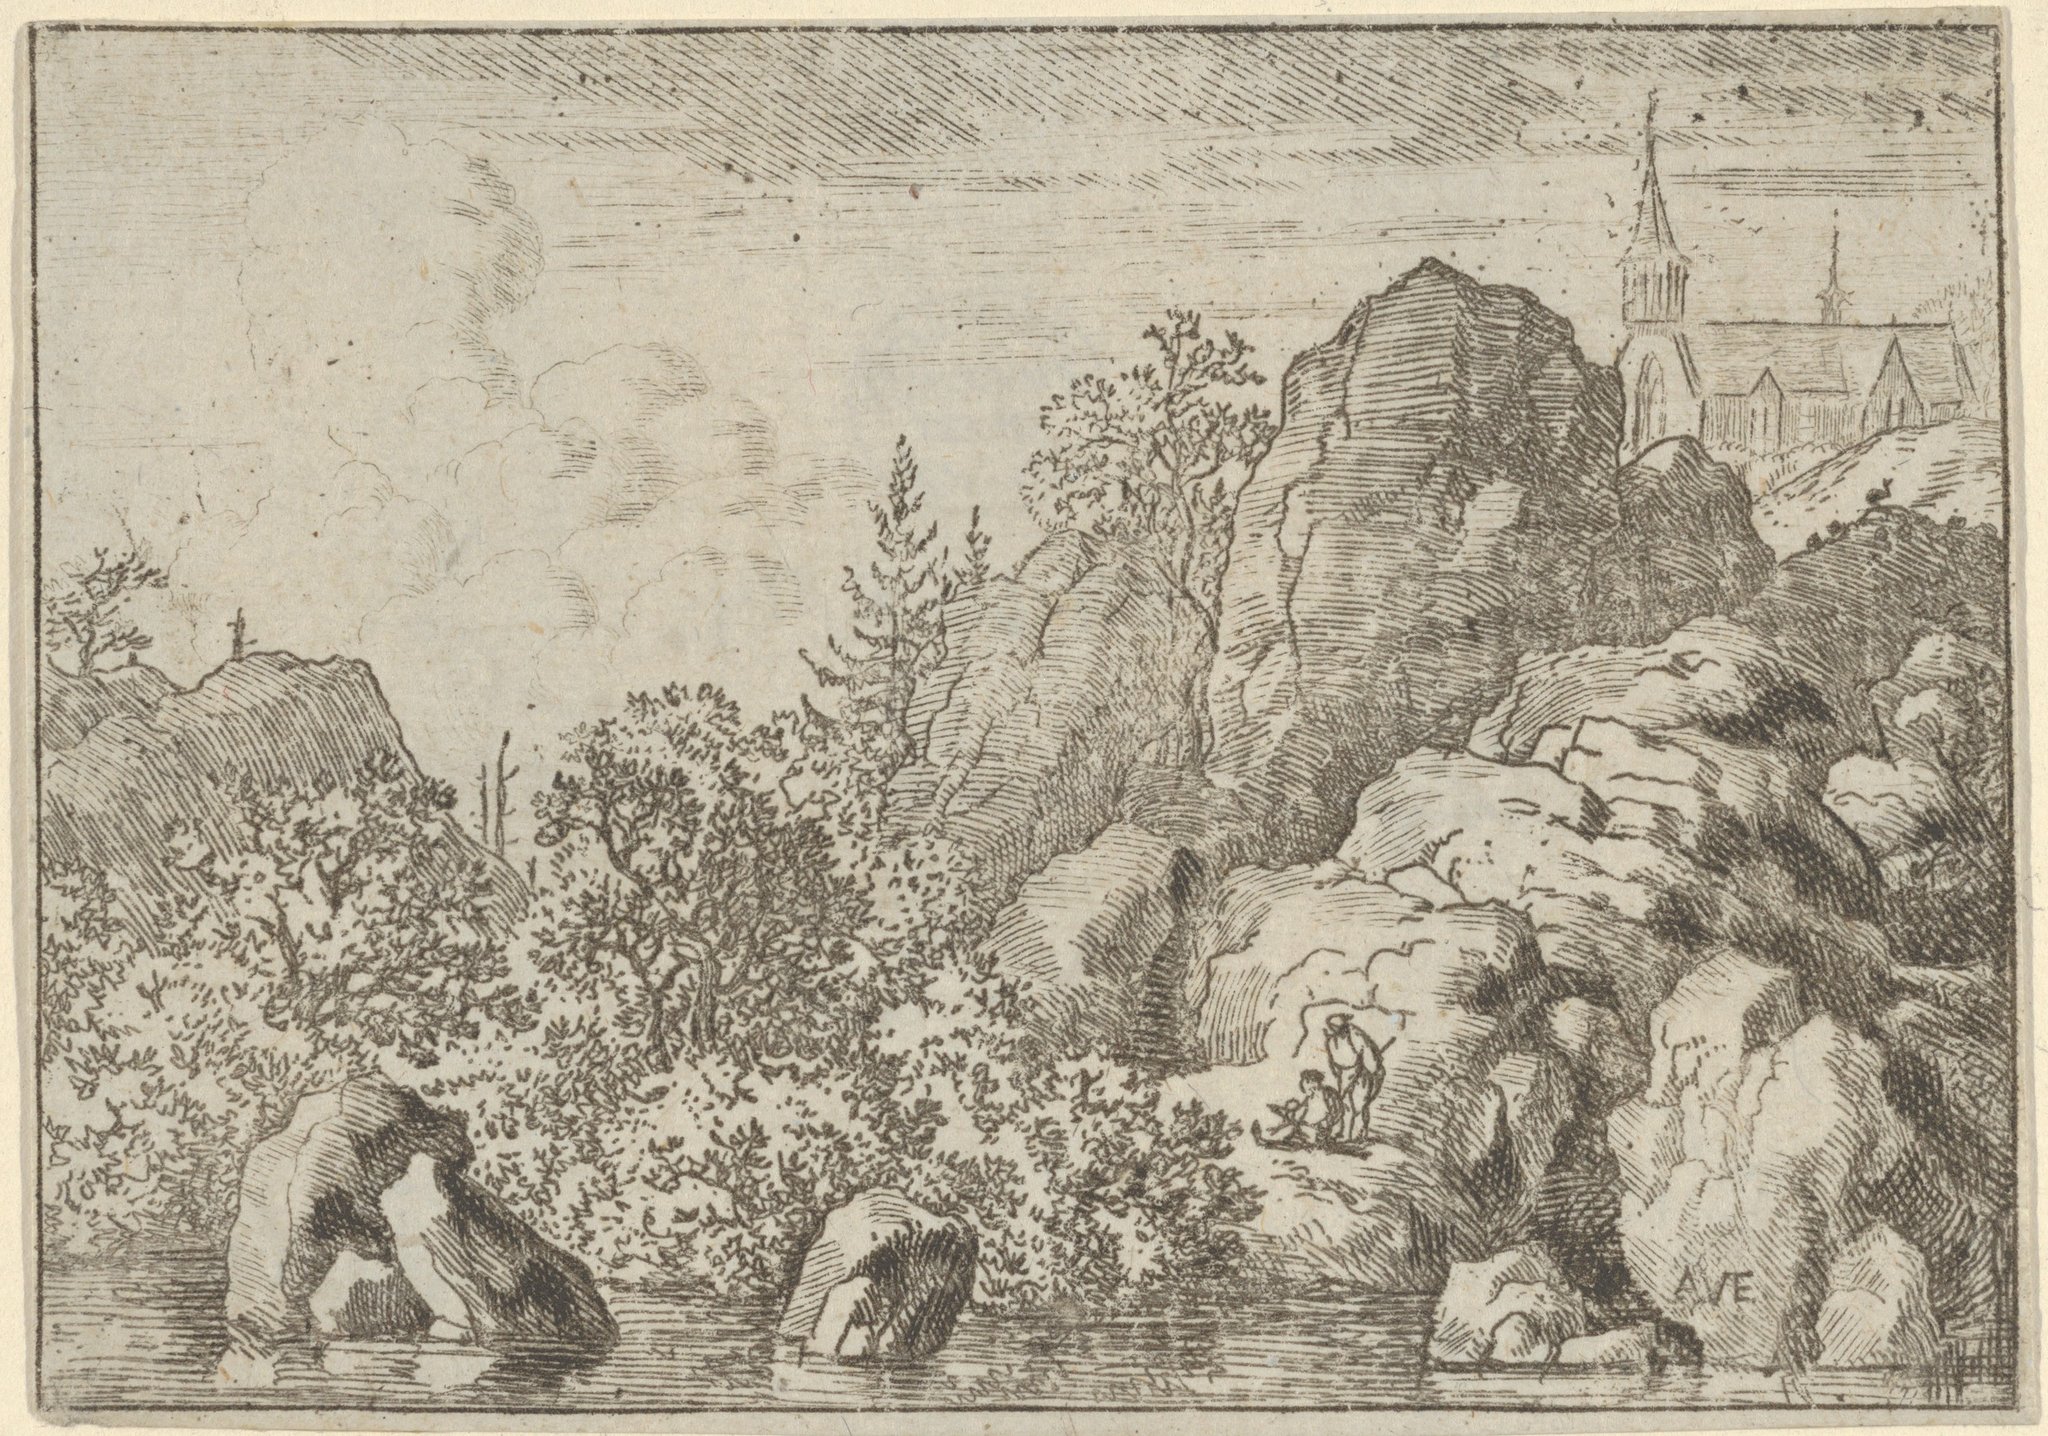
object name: print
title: The Church on the Hill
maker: allart van everdingen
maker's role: artist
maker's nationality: dutch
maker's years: 1621-1675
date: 1621-1675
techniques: engraving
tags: churches,landscapes